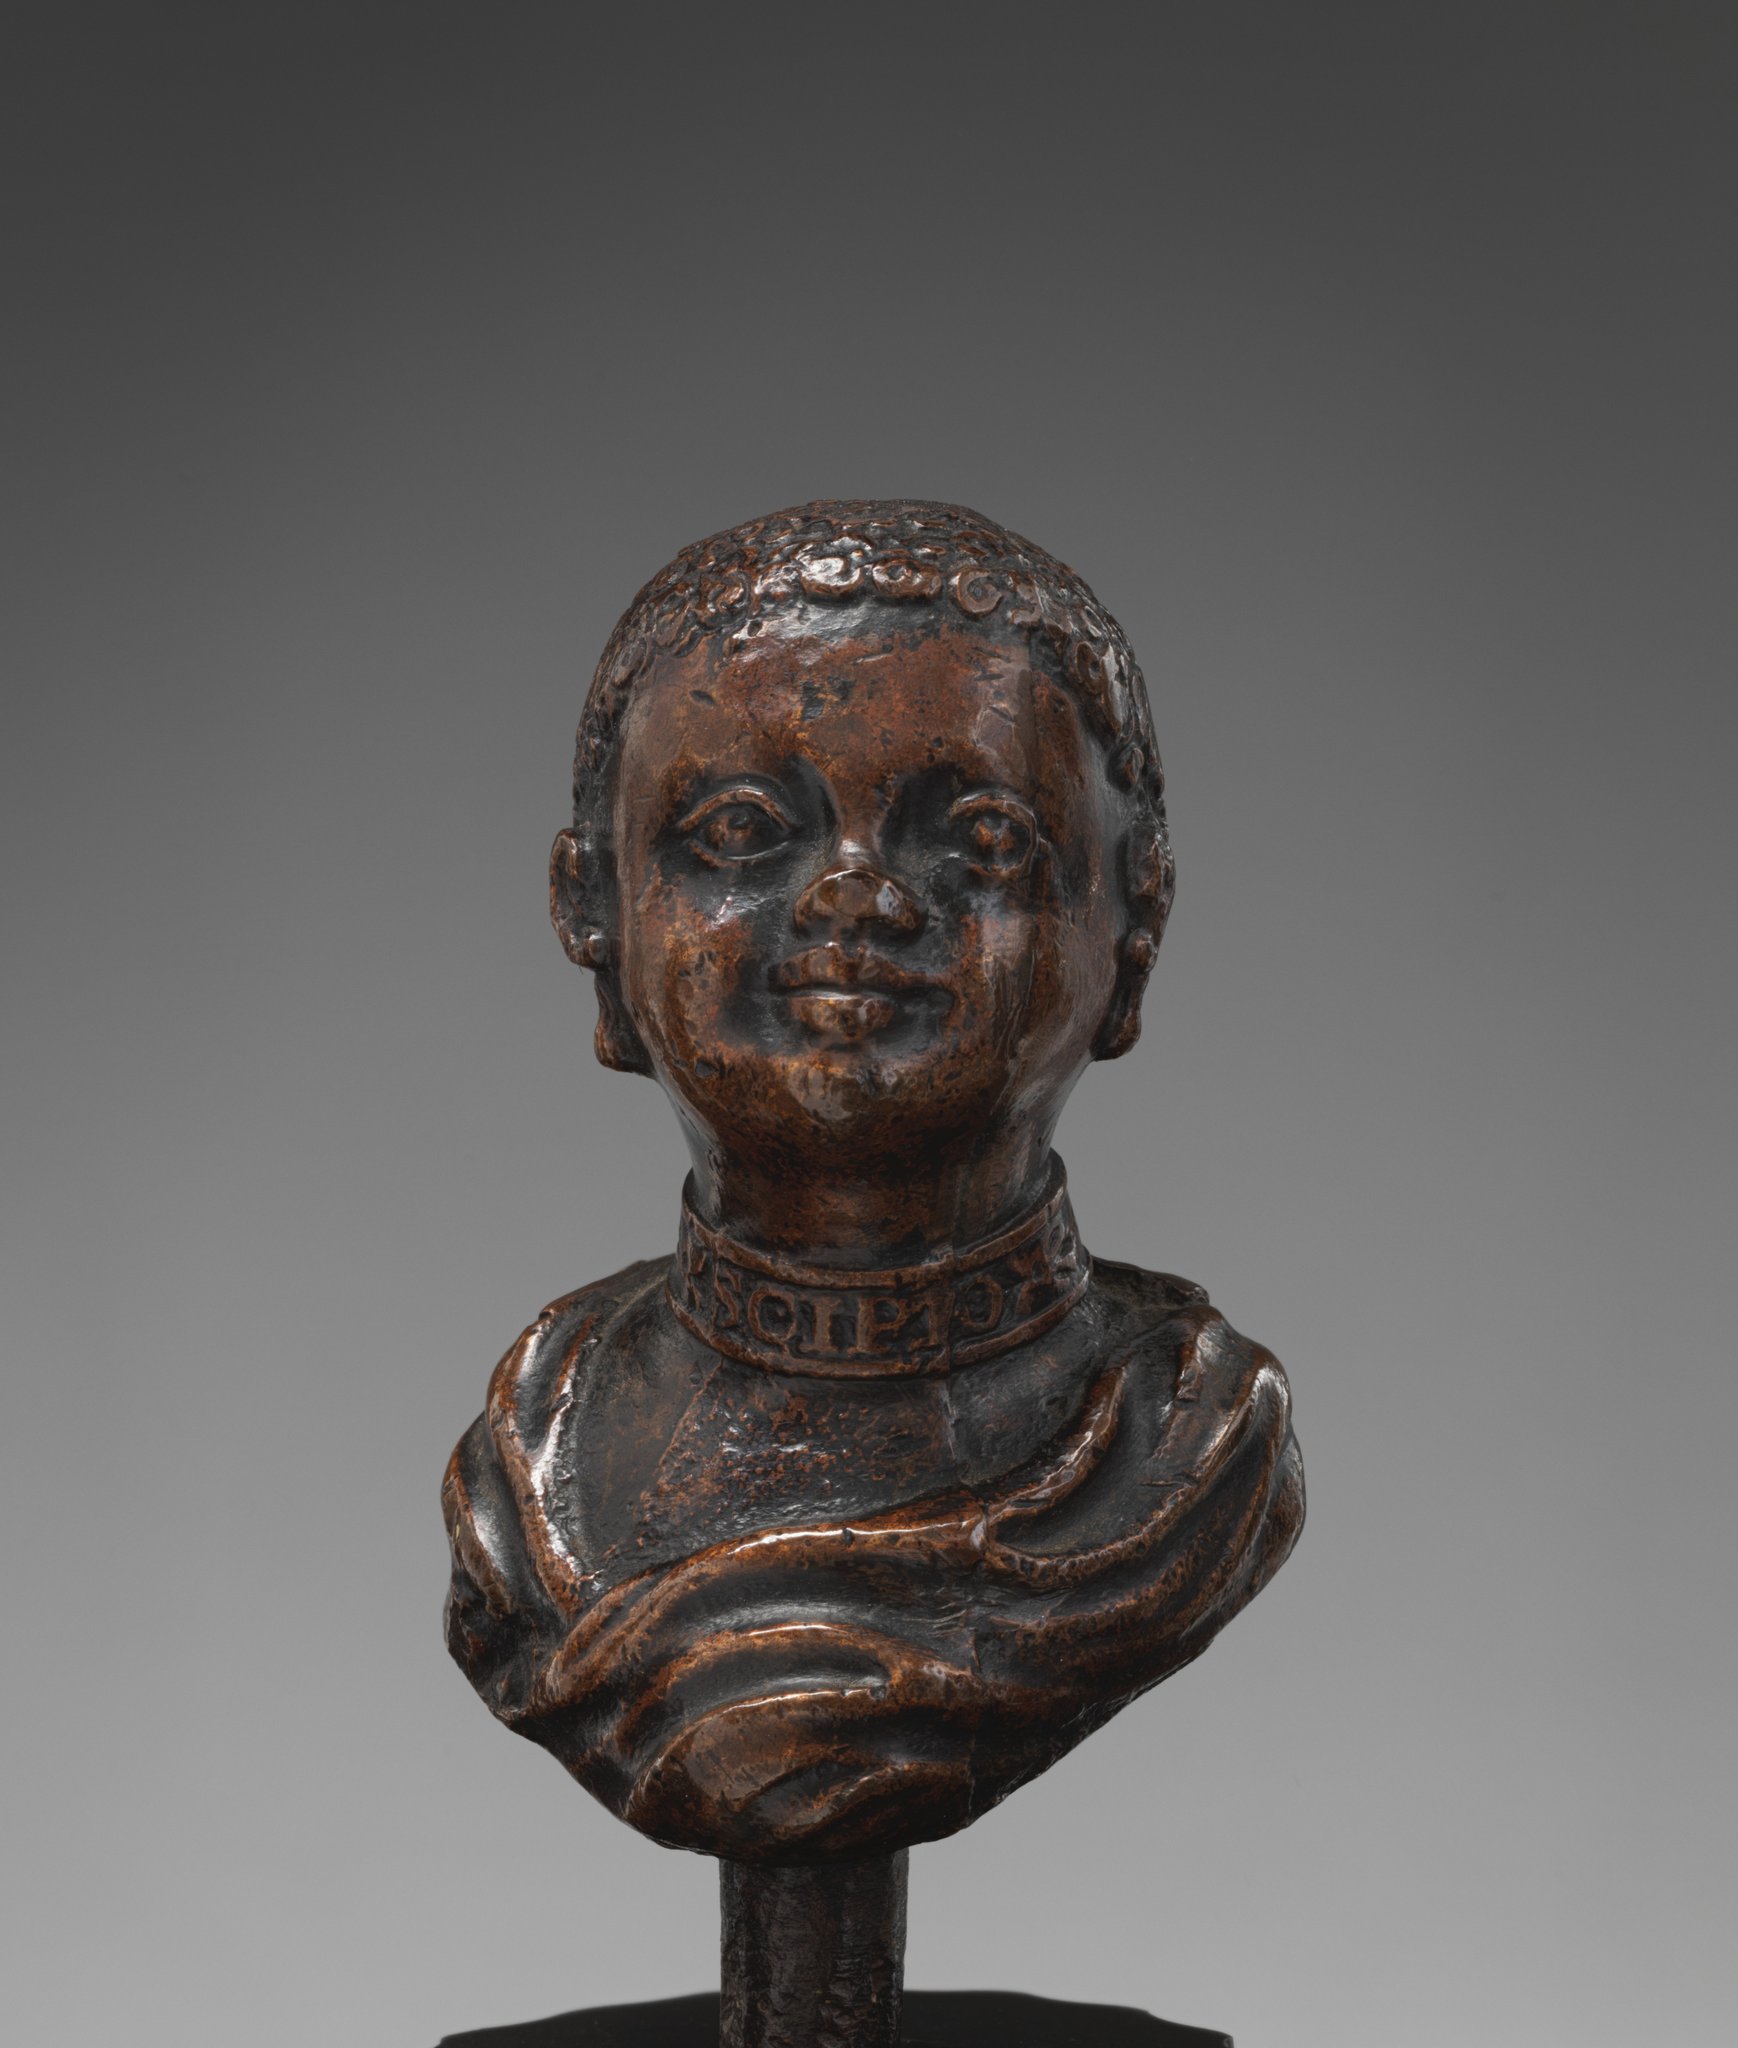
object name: bust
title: Bust of a Scipio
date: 1801-1900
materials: bronze, marble